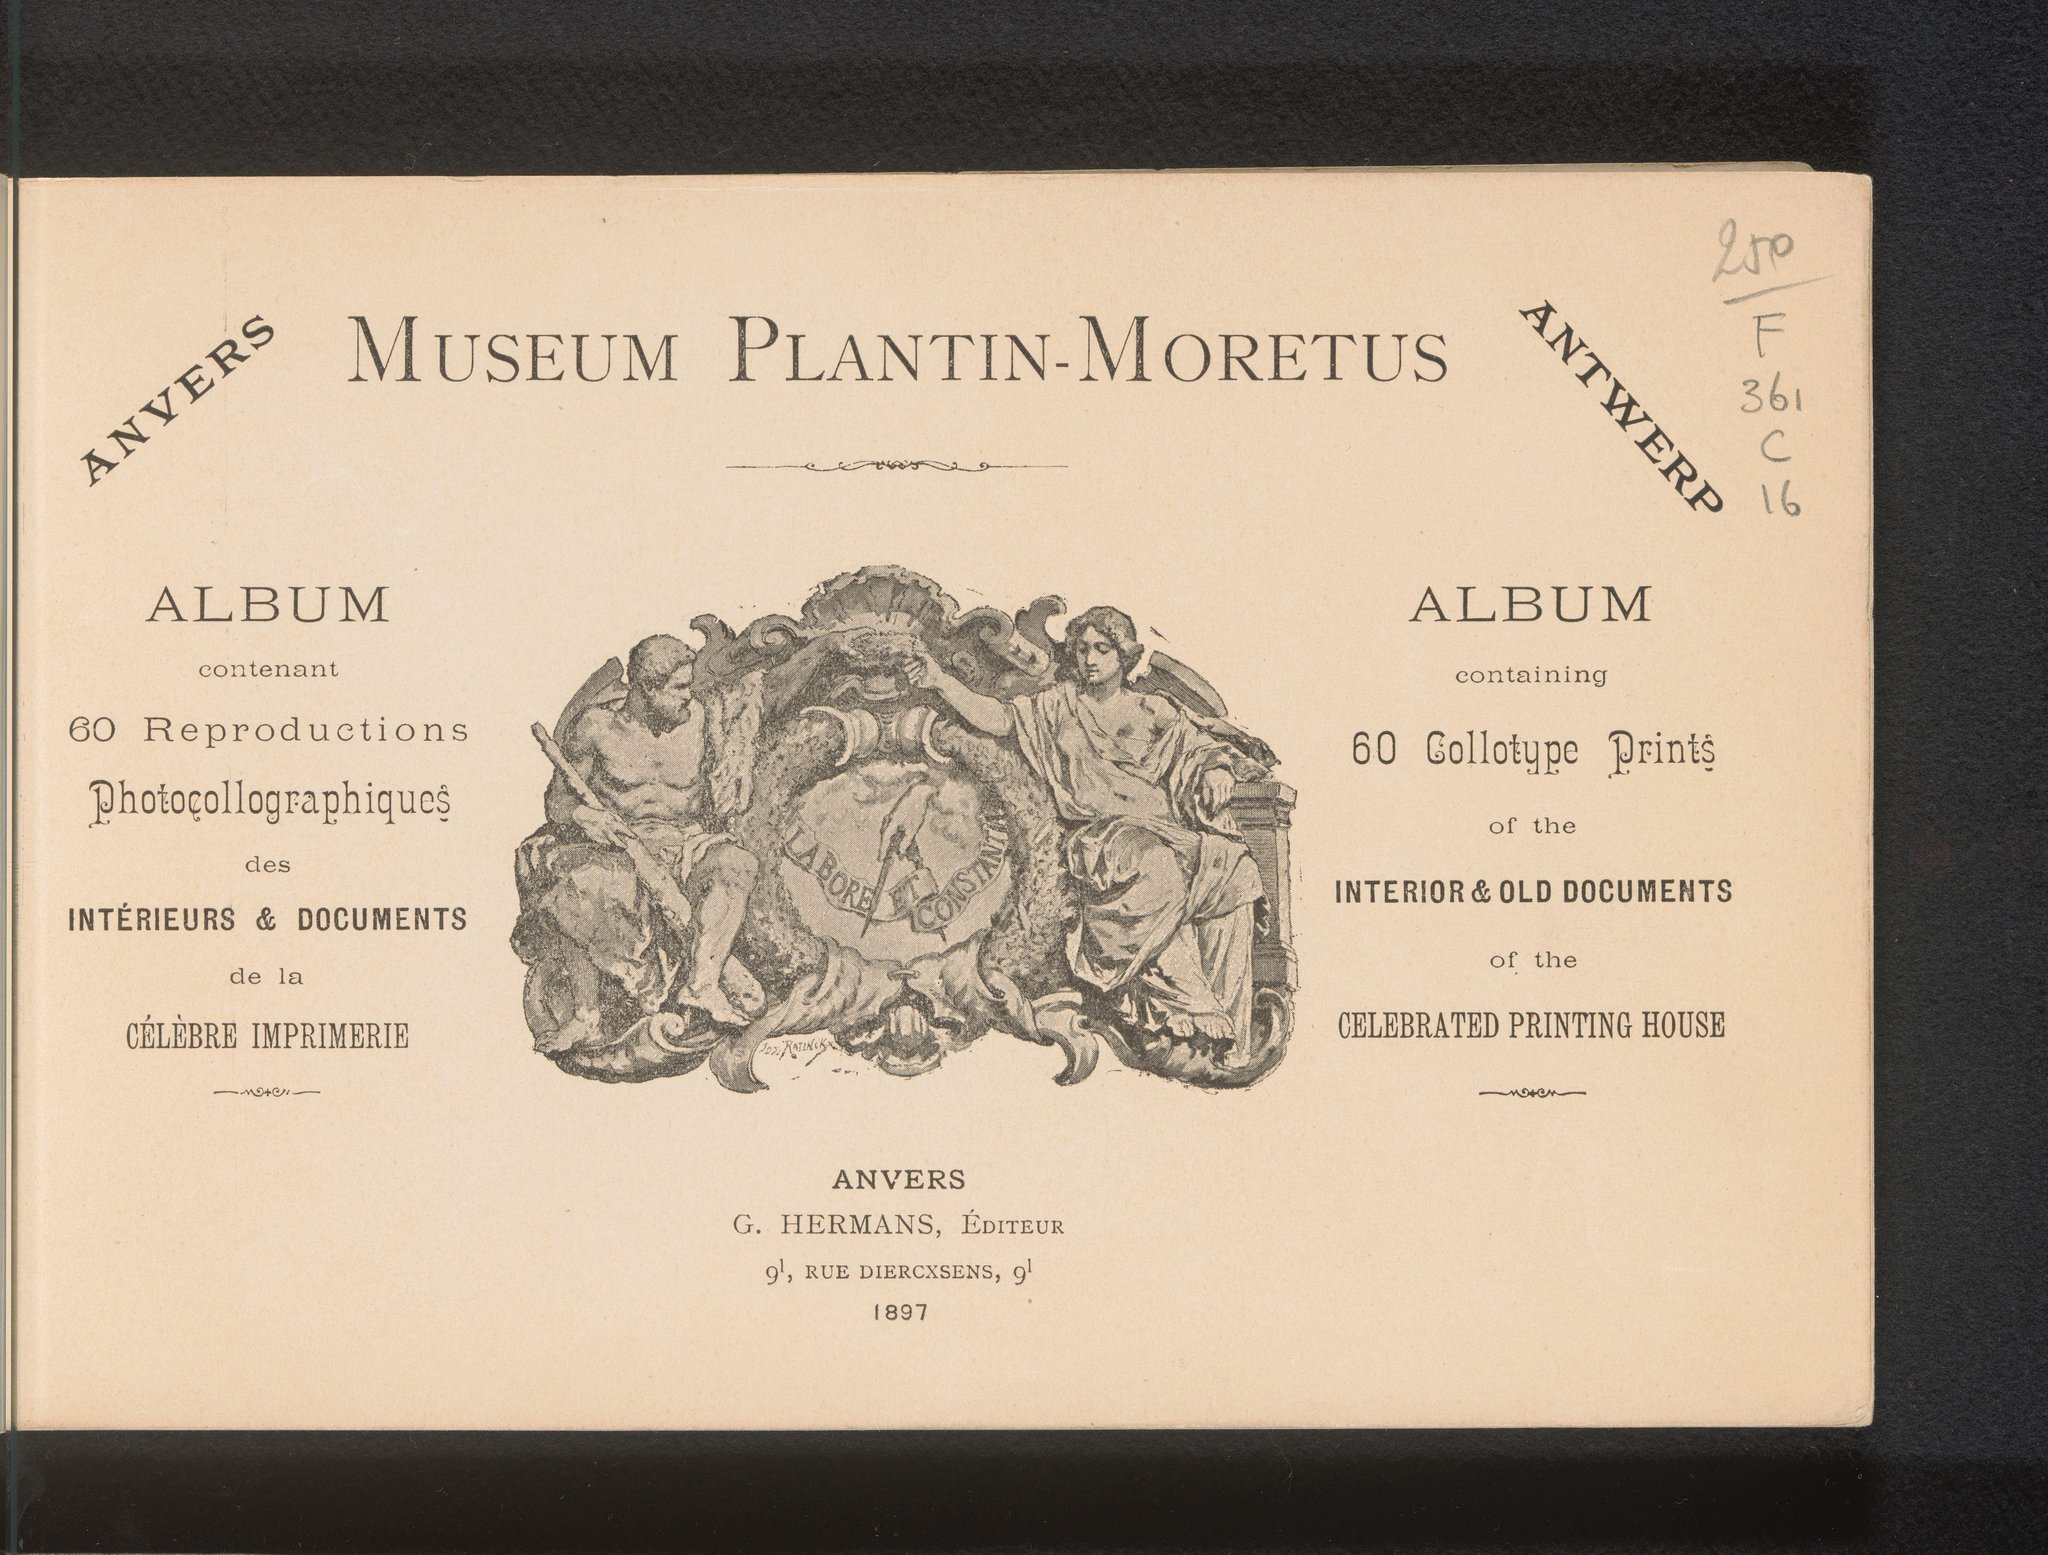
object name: book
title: Museum Plantin-Moretus : Anvers : album contenant 60 reproductions photocollographiques des intérieurs et documents de la célèbre imprimerie = Antwerp : album containing 60 collotype prints of the interior and old documents of the celebrated printing house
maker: gustave hermans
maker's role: publisher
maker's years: 1856-1934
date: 1897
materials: paper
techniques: photograph, printing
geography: antwerp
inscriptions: inscription: ‘JULY/ 1992’